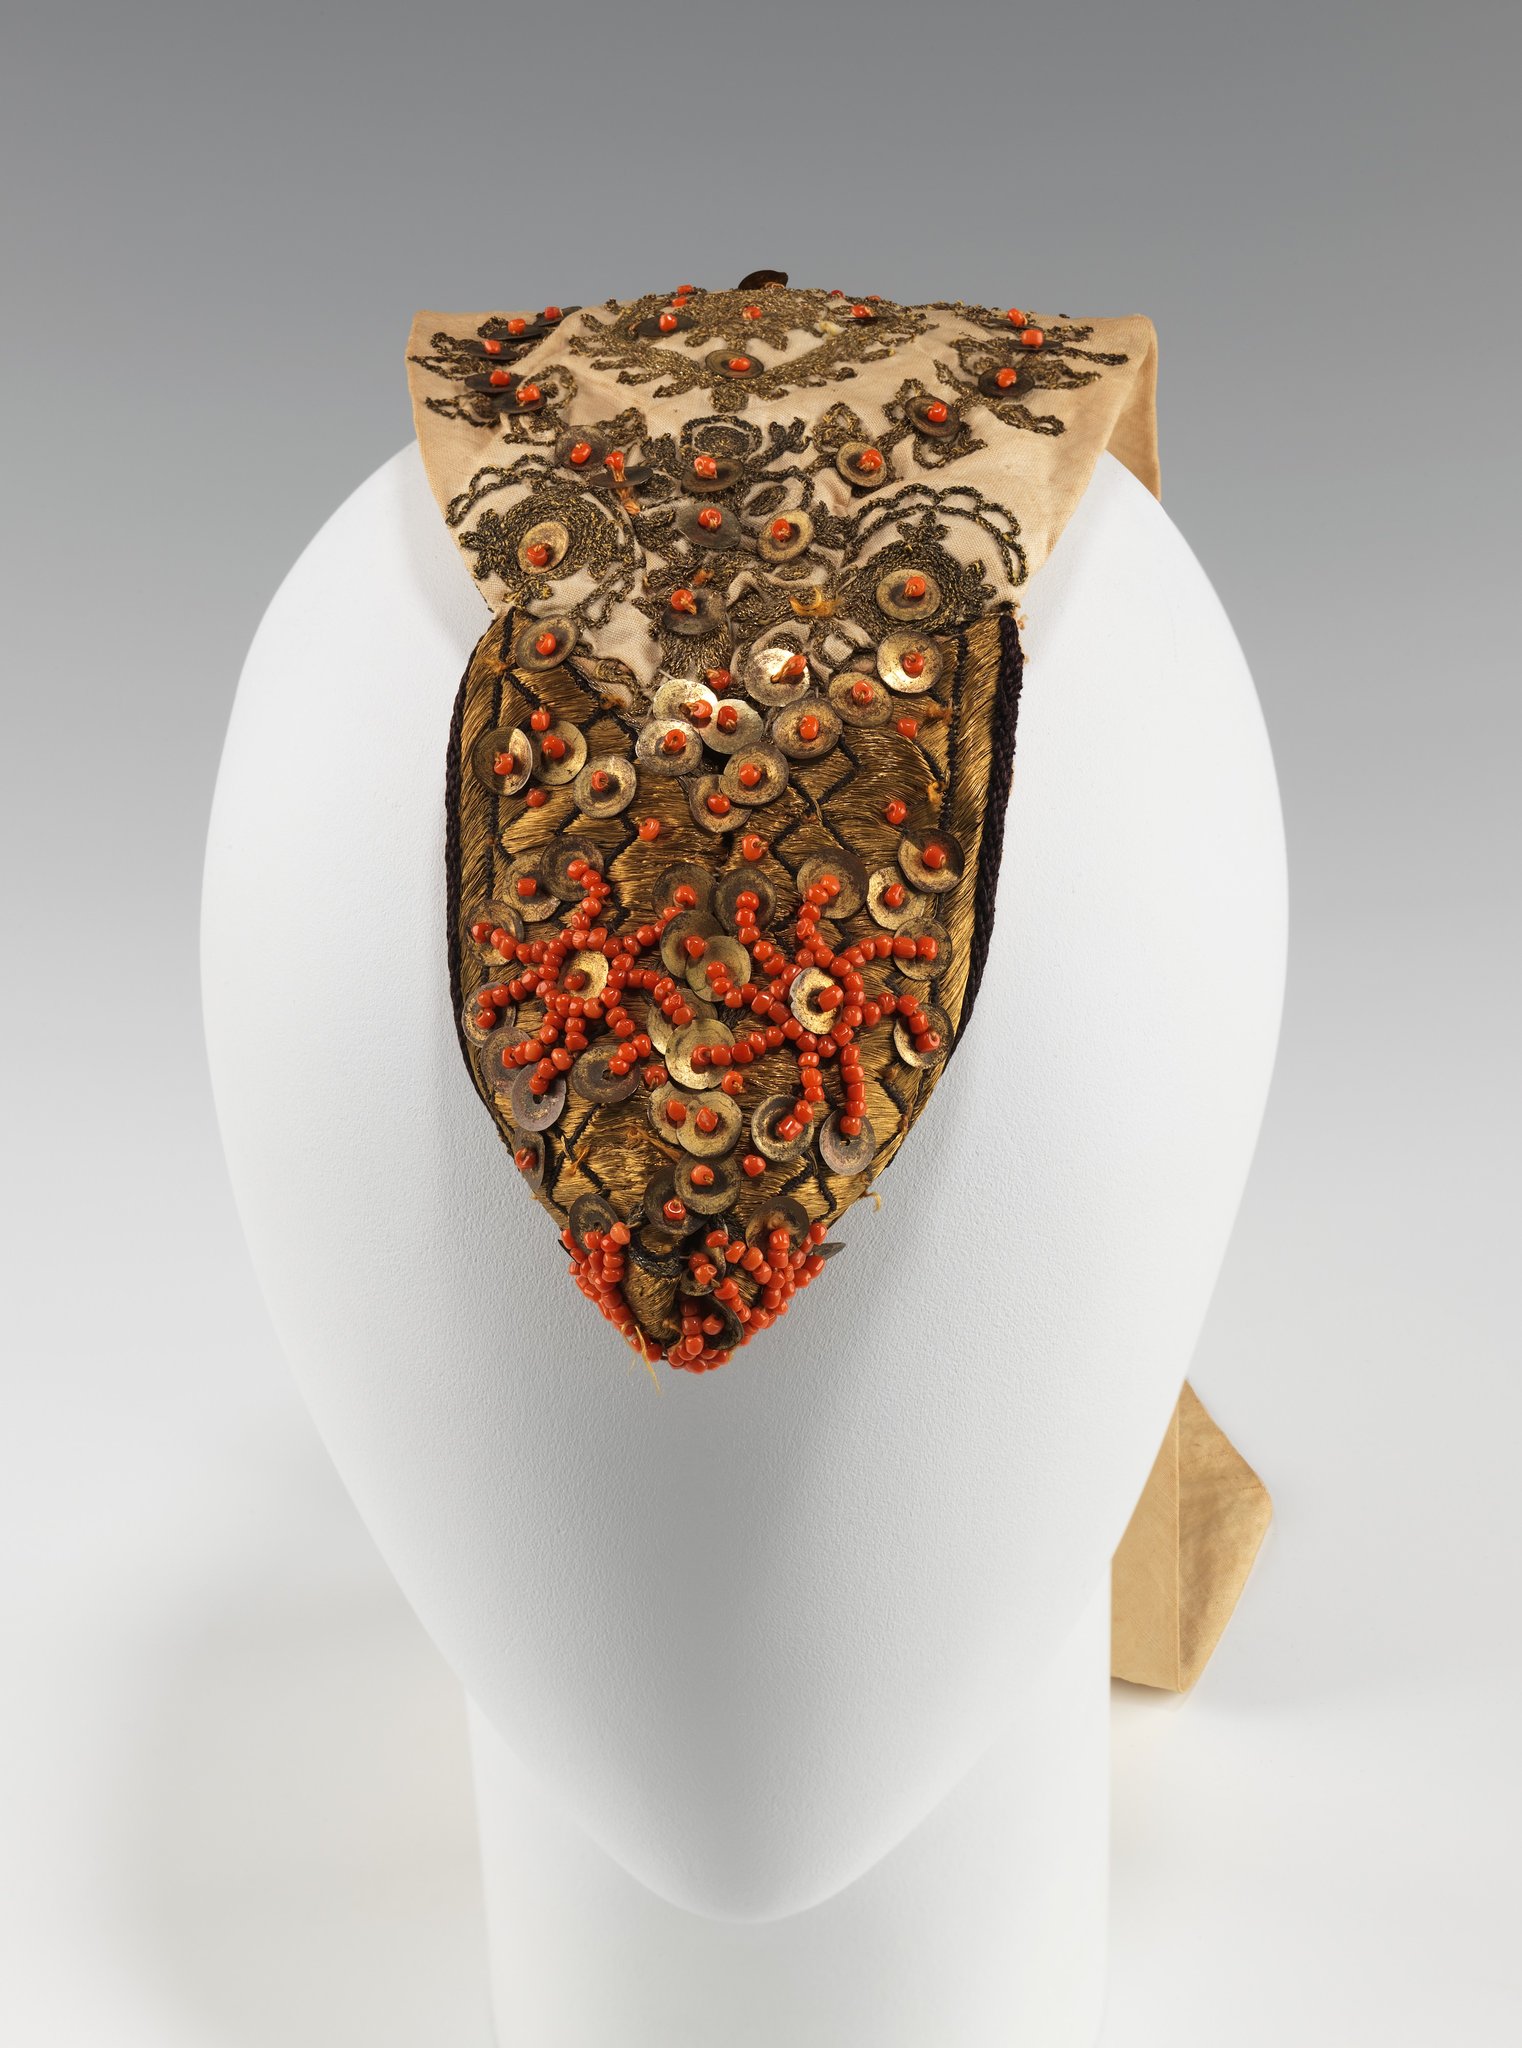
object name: headdress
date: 1867-1900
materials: coral, cotton, metal